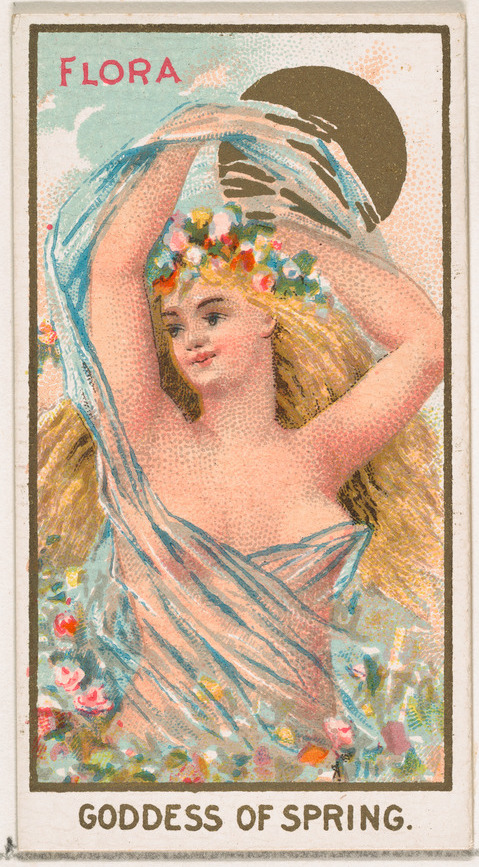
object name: print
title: Flora, Goddess of the Spring, from the Goddesses of the Greeks and Romans series (N188) issued by Wm. S. Kimball & Co.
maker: william s. kimball & company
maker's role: publisher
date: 1889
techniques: color lithograph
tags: spring,goddess